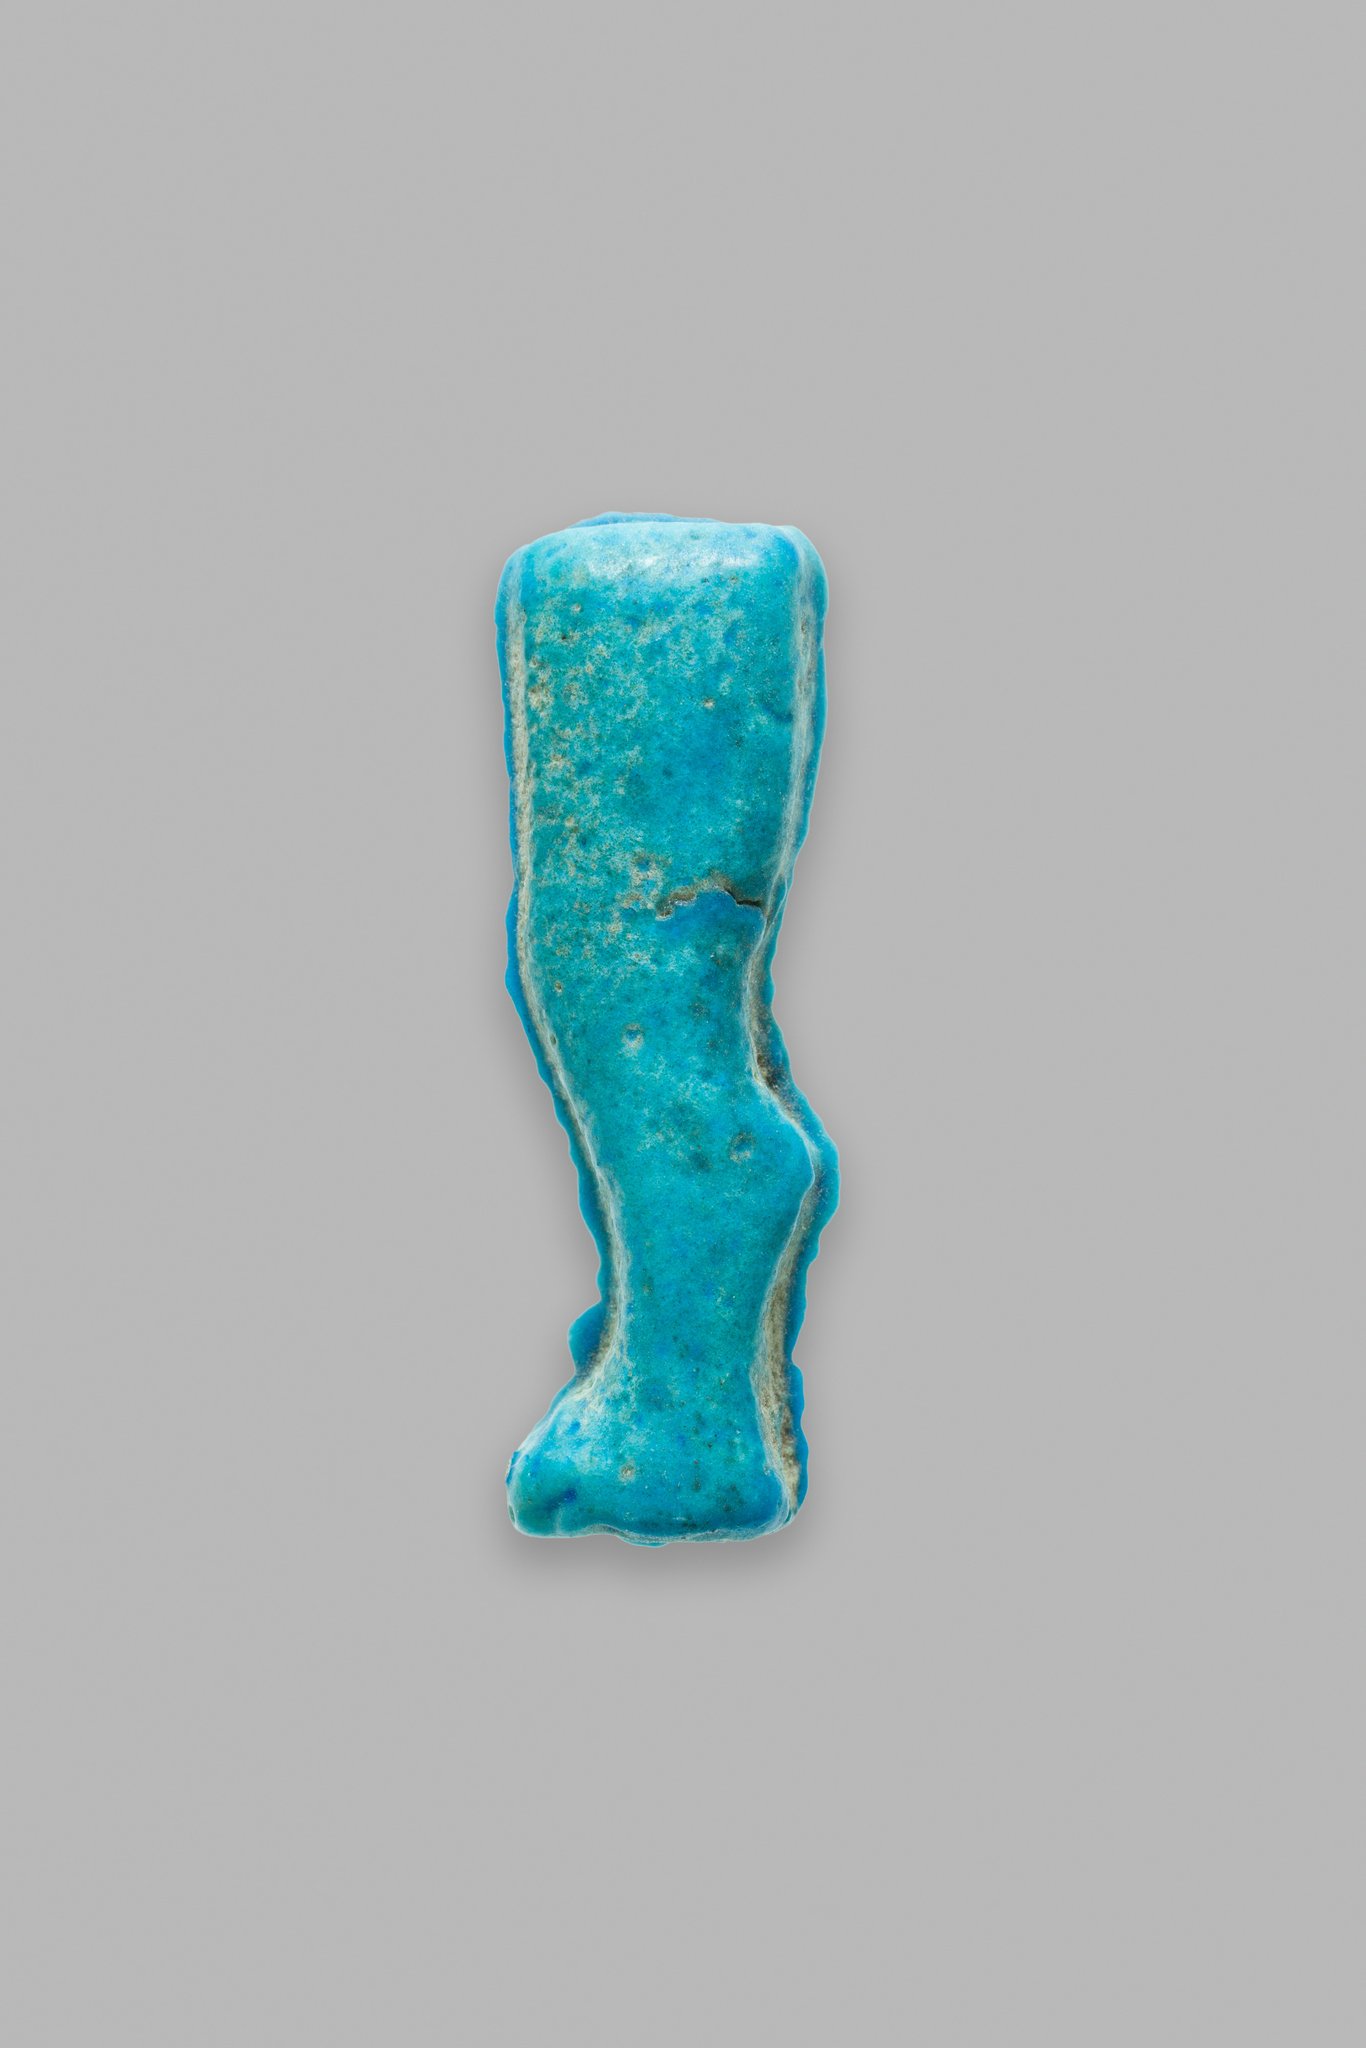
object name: plaque, haunch, foundation deposit, tawosret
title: Foundation Deposit Plaque in the Form of a Haunch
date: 1188-1186 BCE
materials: faience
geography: egypt